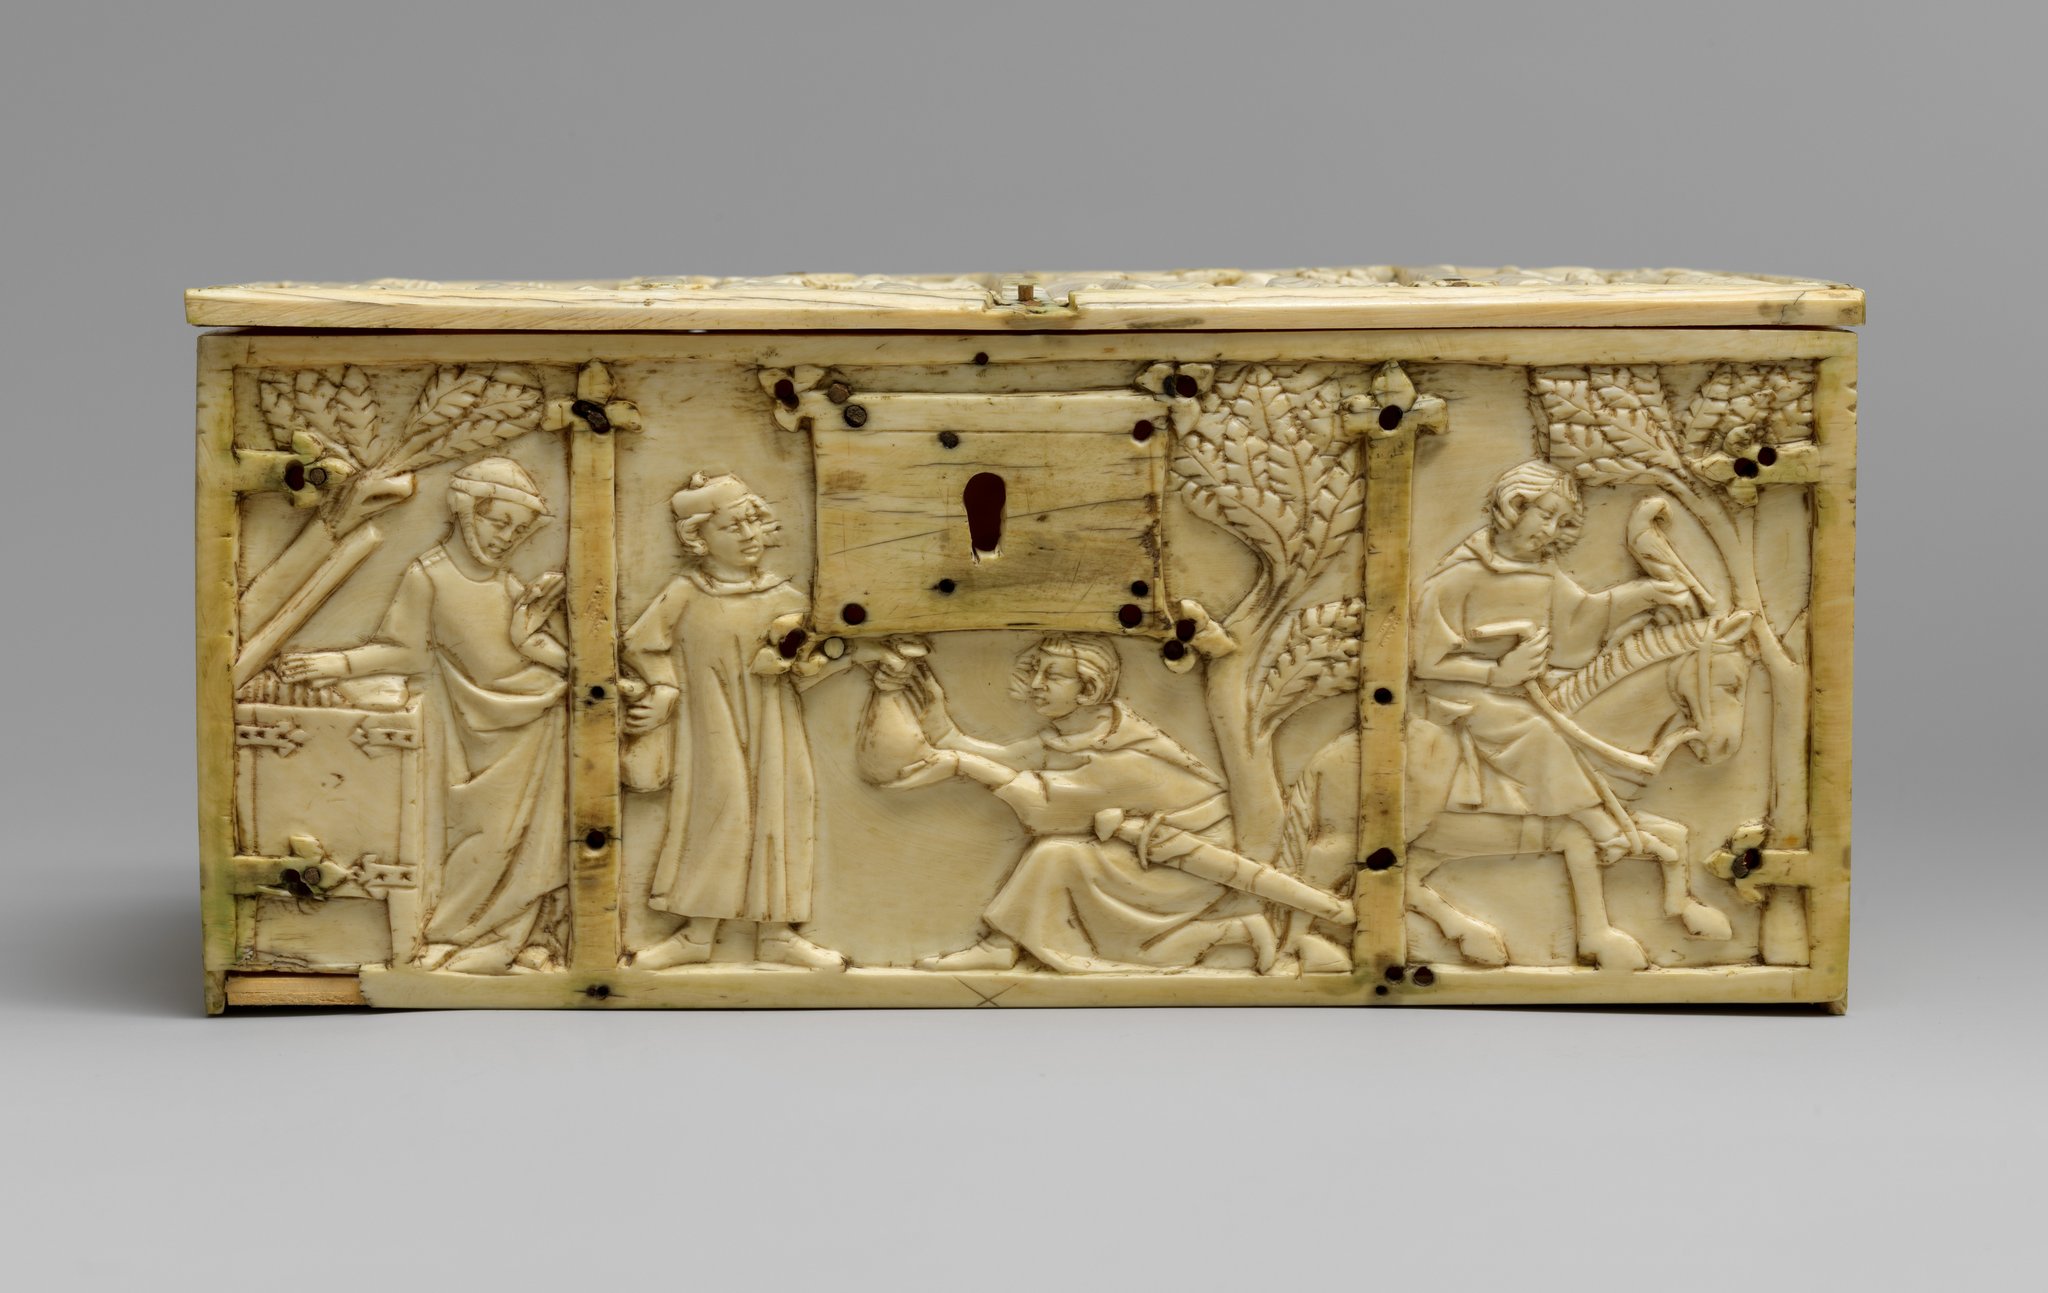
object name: casket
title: Box with the Parable Prodigal Son and Scenes of Lovers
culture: french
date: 1301-1400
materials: ivory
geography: france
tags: men,women,chess,horses